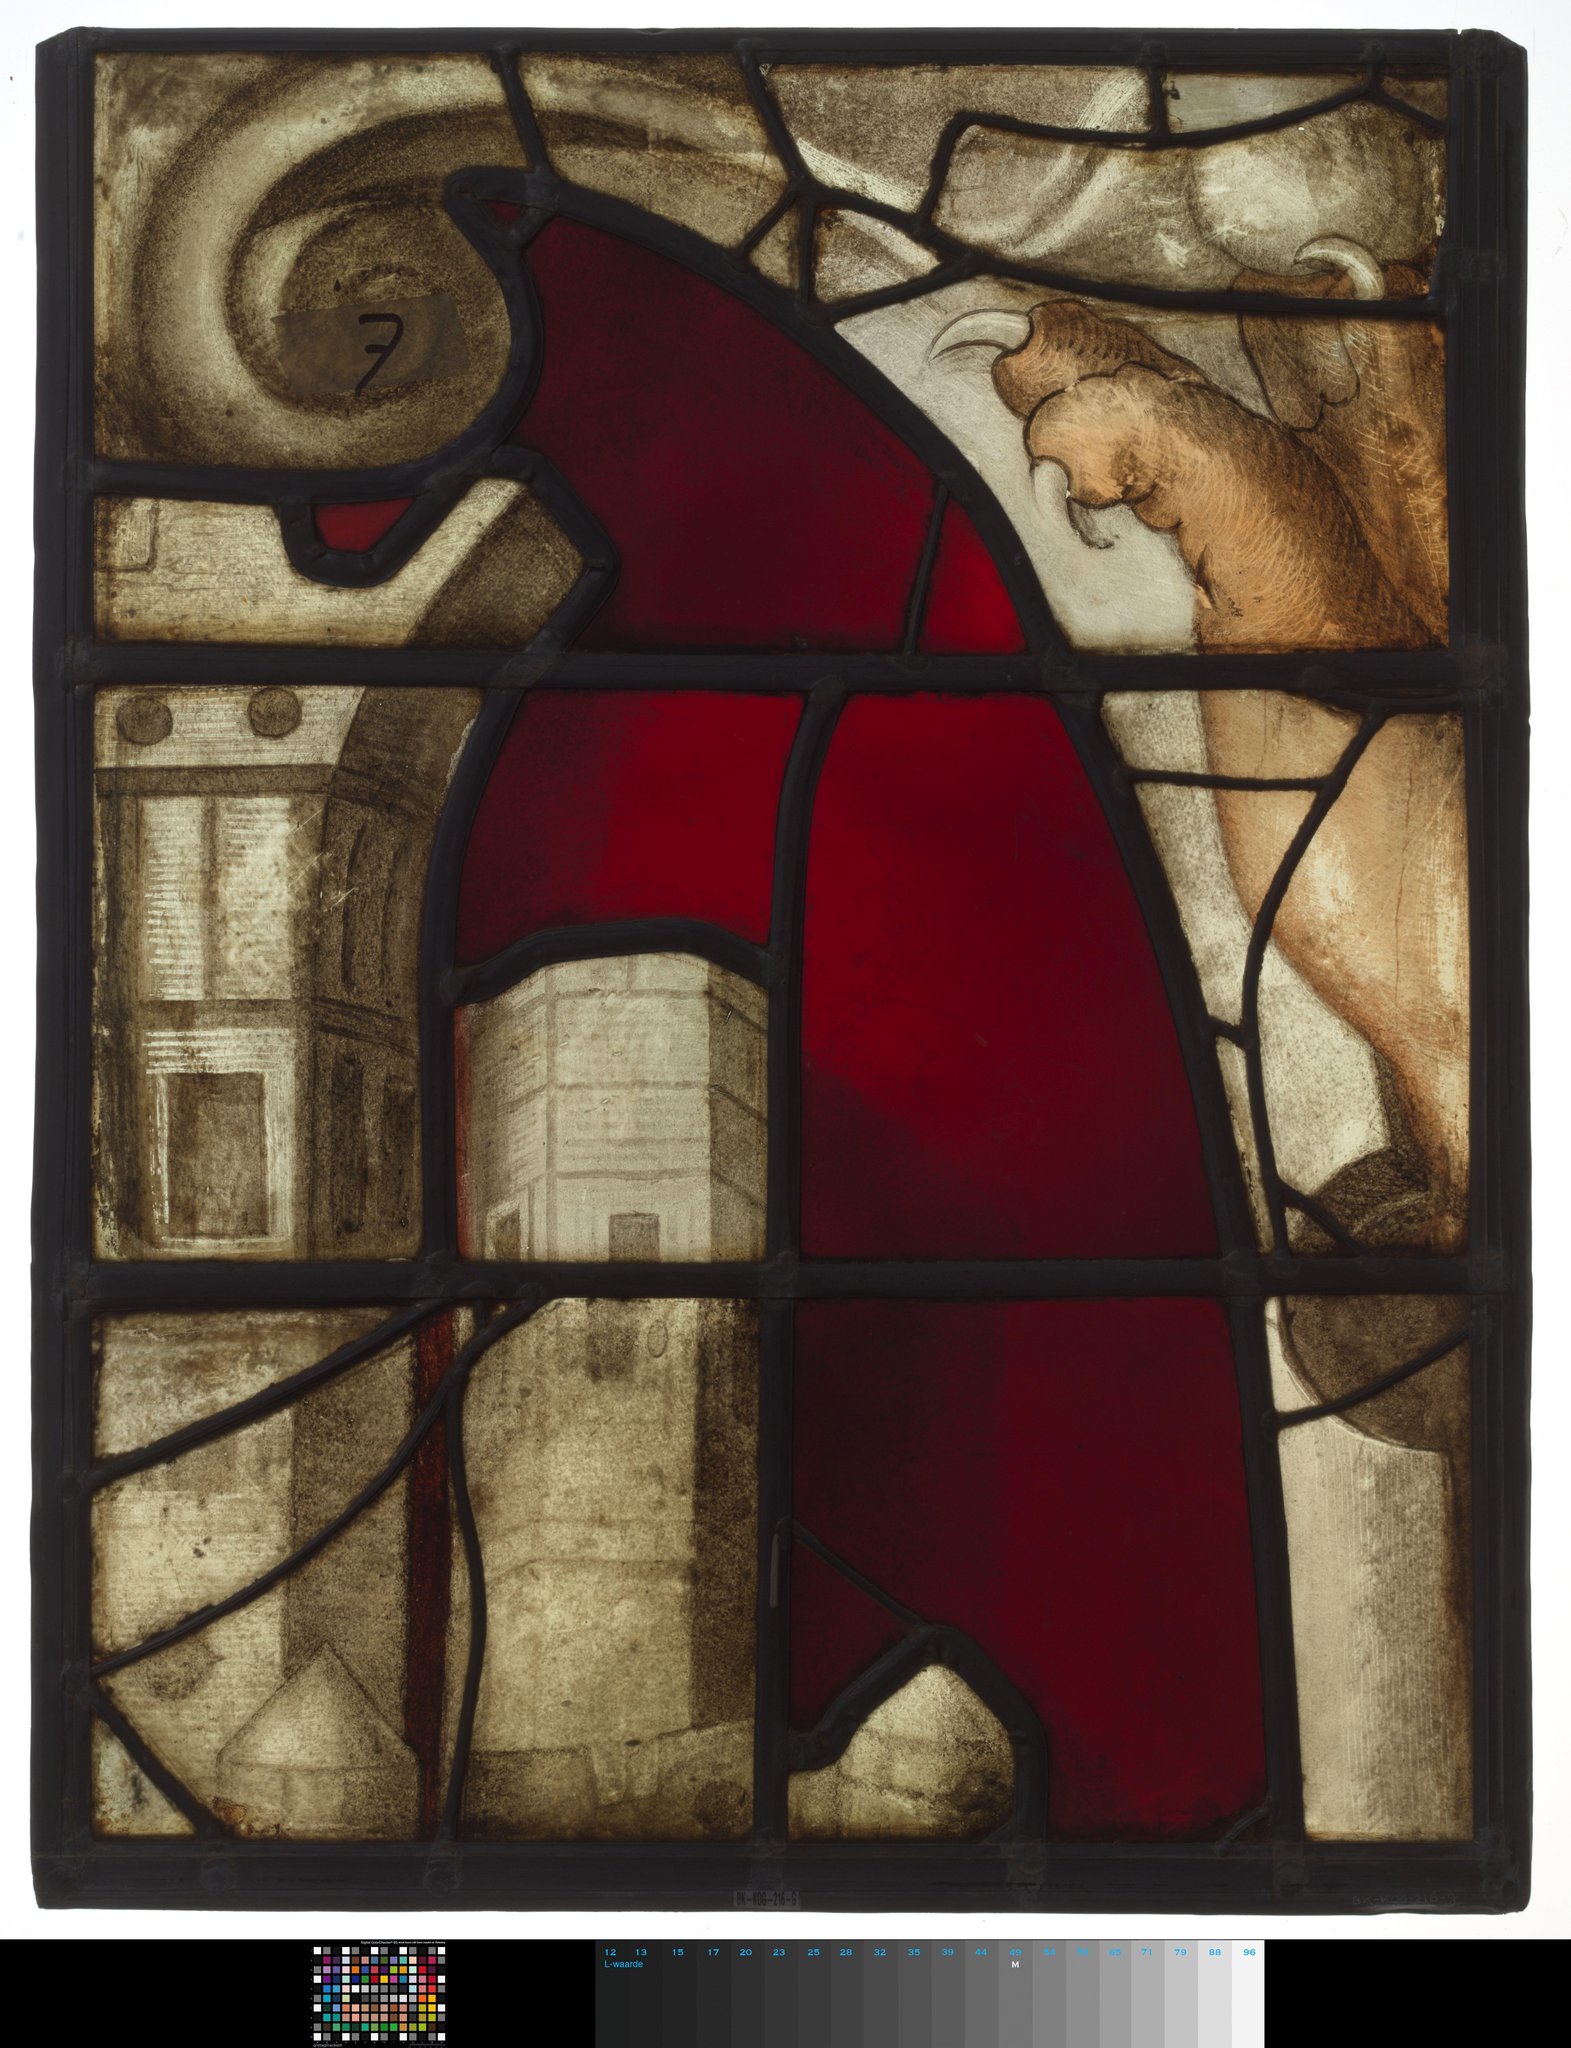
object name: light window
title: Ruit met het wapen van Alkmaar met onderschrift "Alkmaria Victrix 1573"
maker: Anonymous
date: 1573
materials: glass, lead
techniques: leading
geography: netherlands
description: Ruit, glas-in-lood, bestaande uit zestien afzonderlijke panelen die tezamen het wapen van Alkmaar laten zien. Onderschrift: ALKMARIA VICTRIX. Gedateerd 1573.